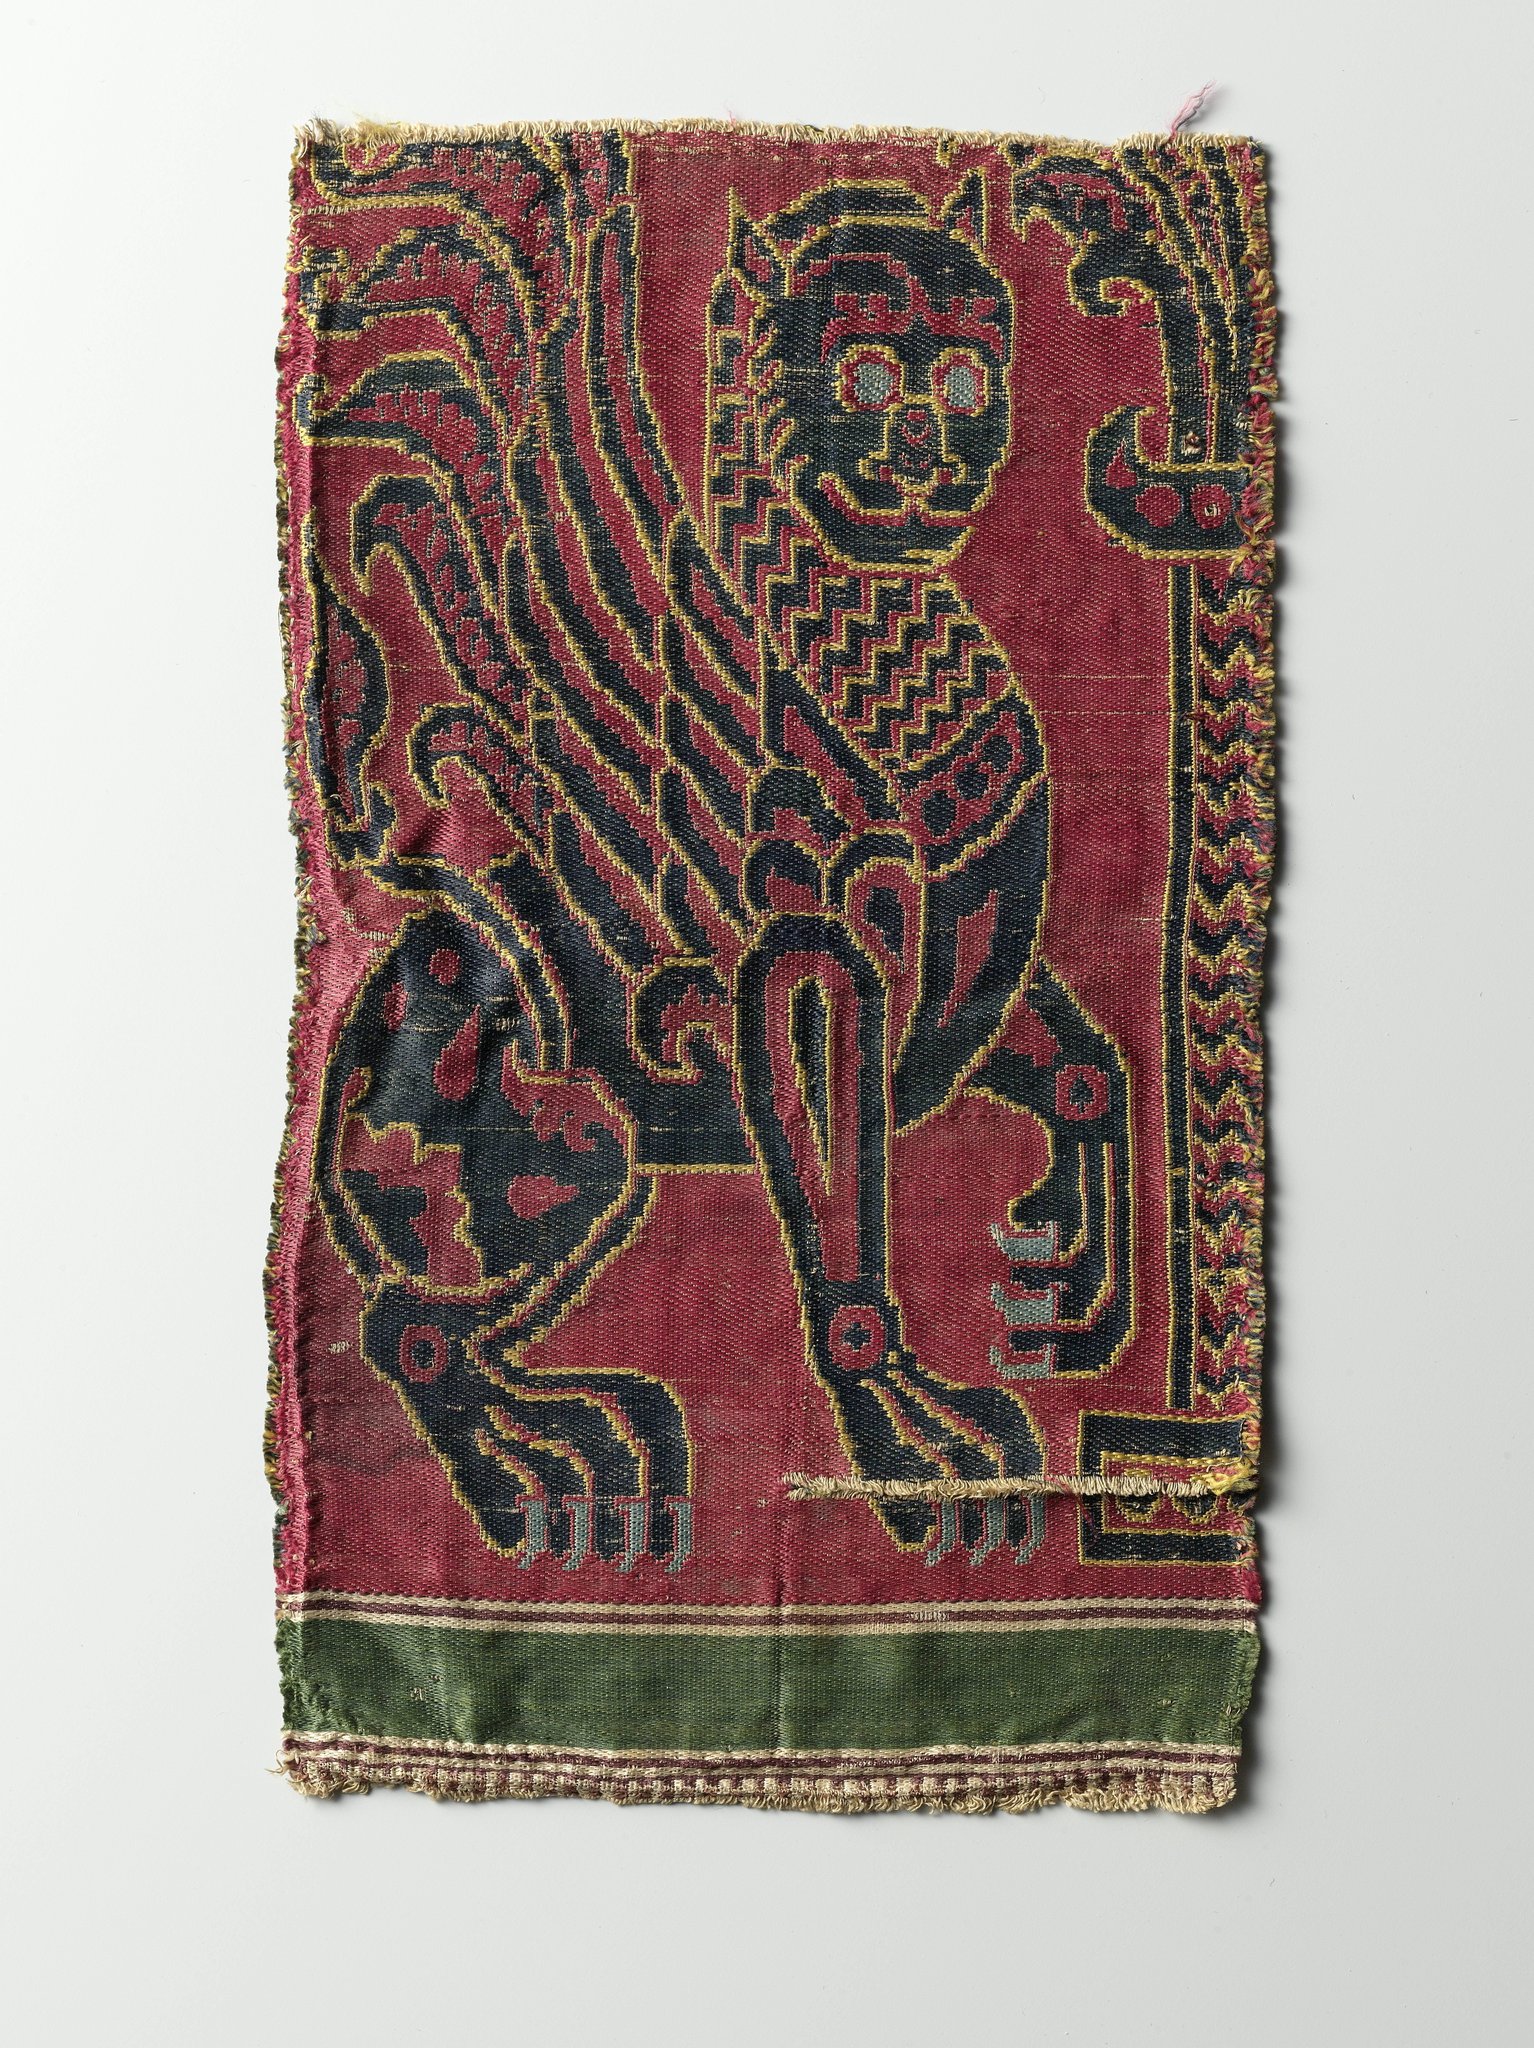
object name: fragment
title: Fragment samiet met gevleugelde leeuw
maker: Anonymous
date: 1200-1399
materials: silk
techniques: samite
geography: spain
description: Fragment van rode zijde met voorstelling van naar rechts gewende zwarte zittende gevleugelde leeuw met één opgetrokken poot, blauwe ogen en nagels en met gele contour.